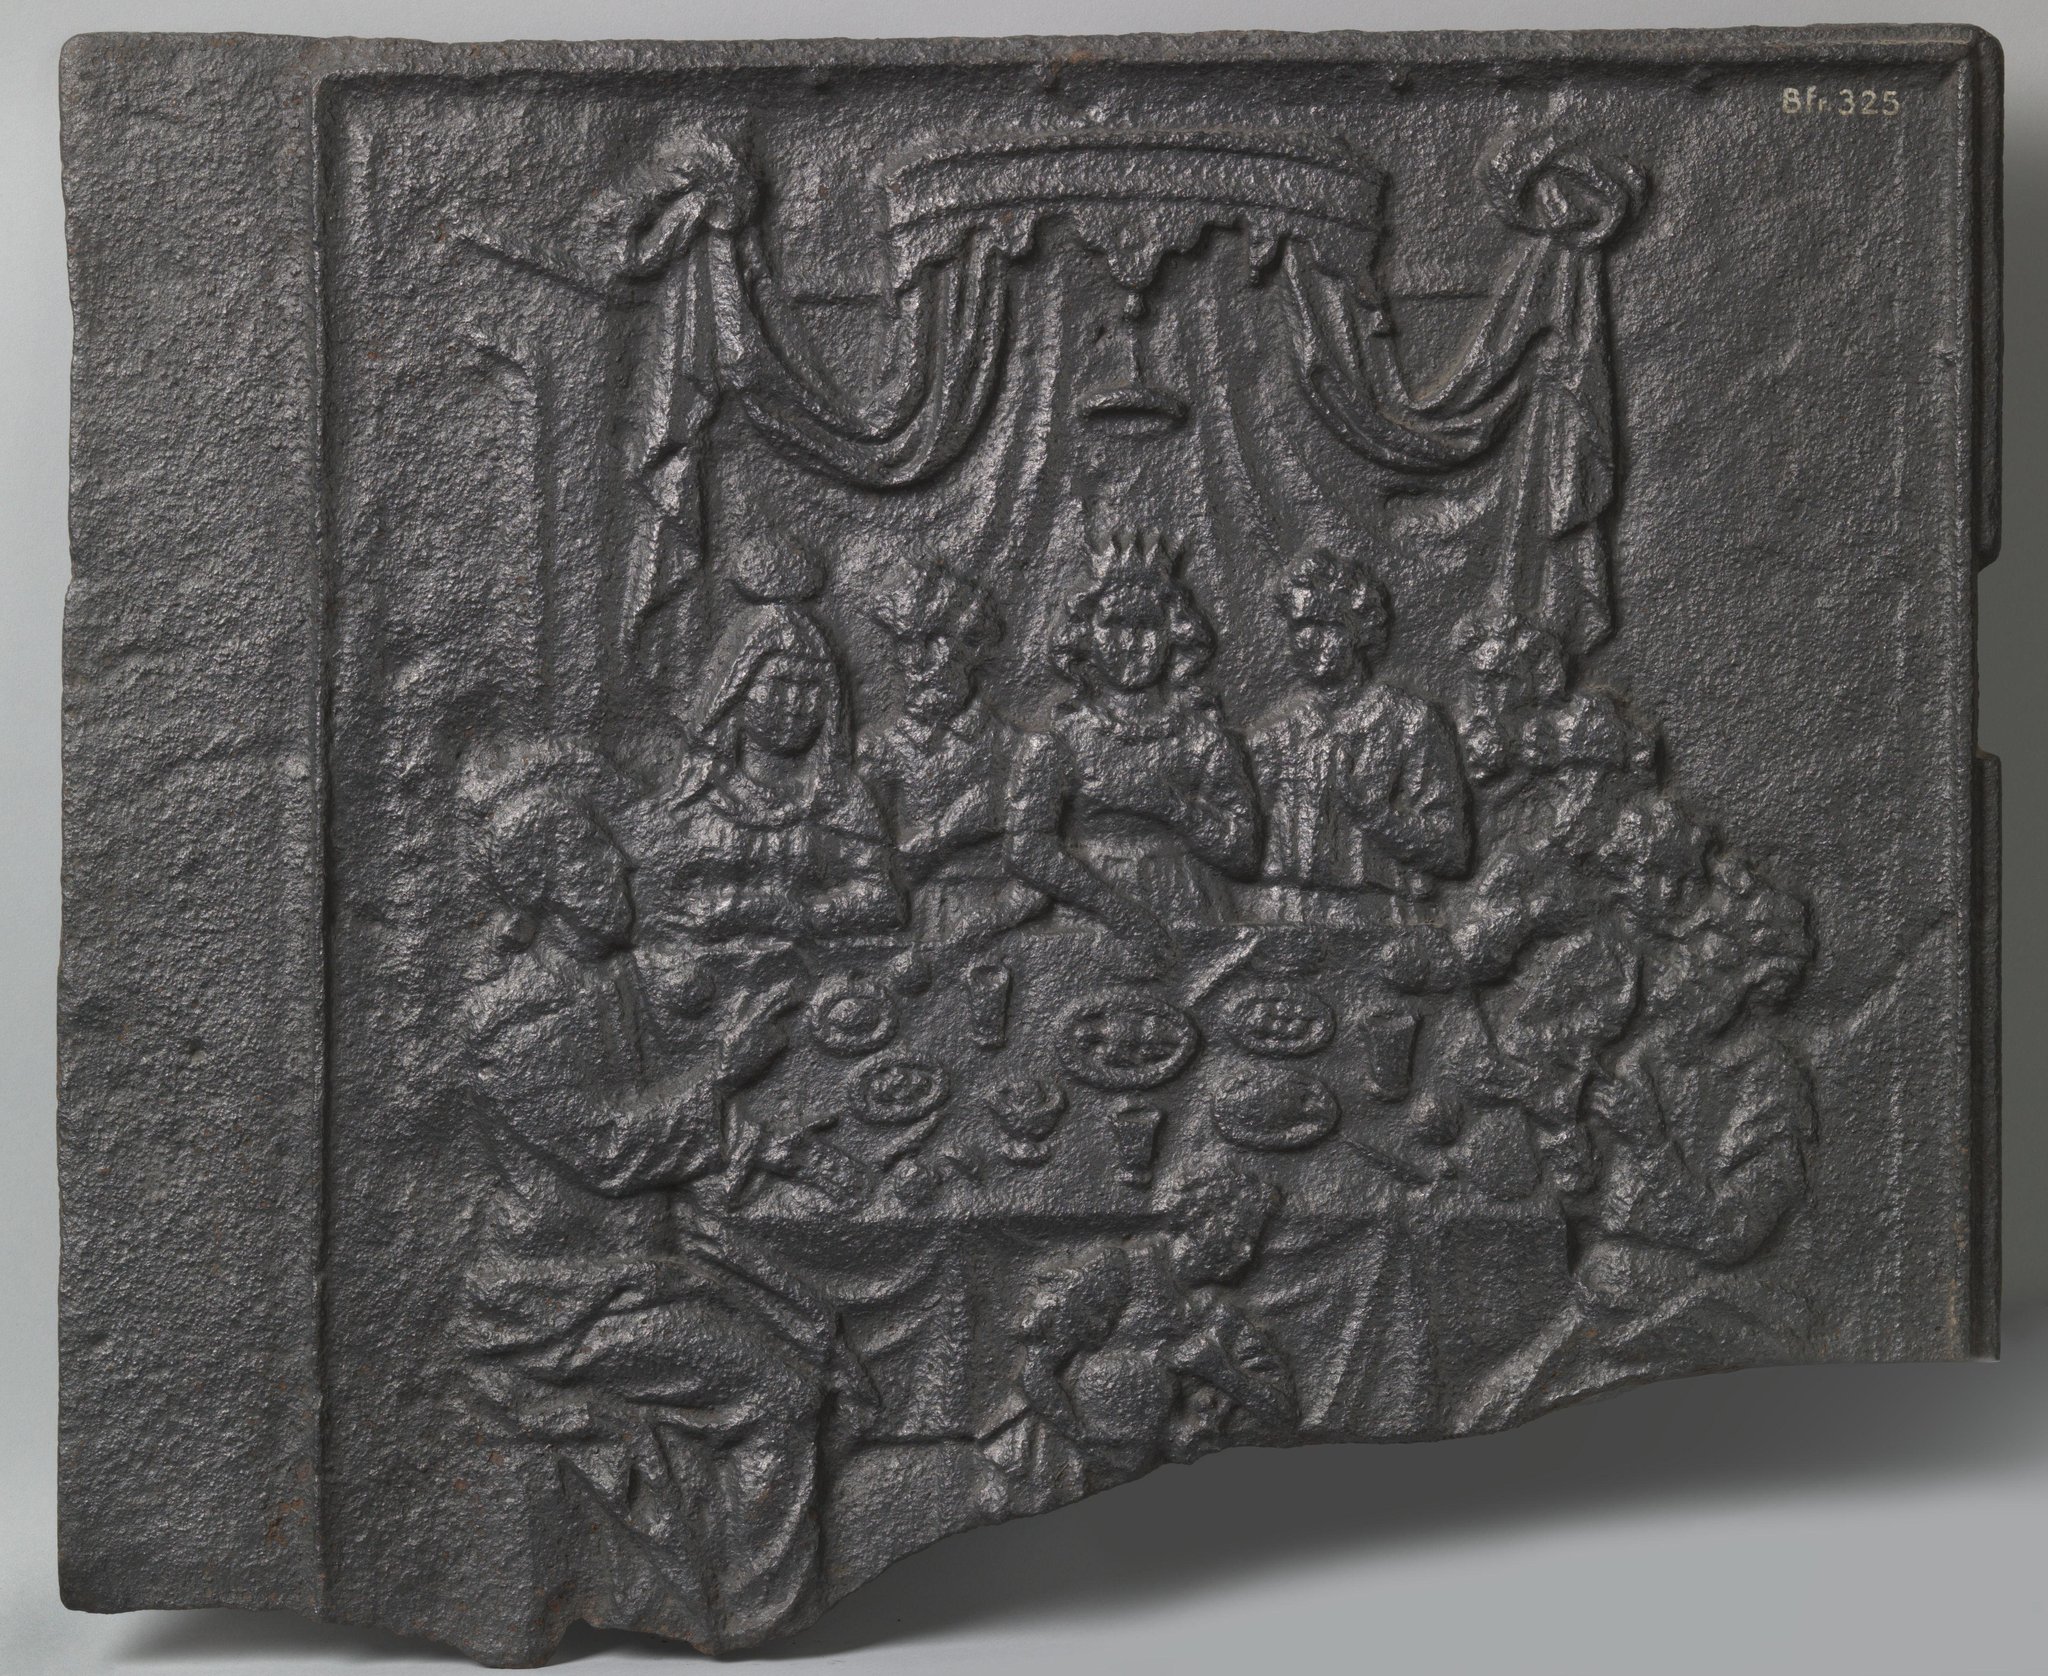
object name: fragment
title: Kachelplaat met voorstelling van de bruiloft te Kana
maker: Anonymous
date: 1575-1625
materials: iron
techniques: casting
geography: siegerland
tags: christ orders (six) jars to be filled with water ~ marriage-feast at cana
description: Gietijzeren kachelplaat, verdeeld in twee zones. In de bovenste zone is de bruiloft te Kana afgebeeld. Centraal is de lange, gedekte tafel te zien, waaraan de gasten zitten. Midden aan tafel zit de bruid met een kroon op haar hoofd en een krans en baldakijn boven haar. Geheel links zit Jezus. Op de voorgrond vult een van de bedienden de zes kruiken. De onderste zone is niet bewaard gebleven. De onderrand van het tafereel is deels afgebroken.